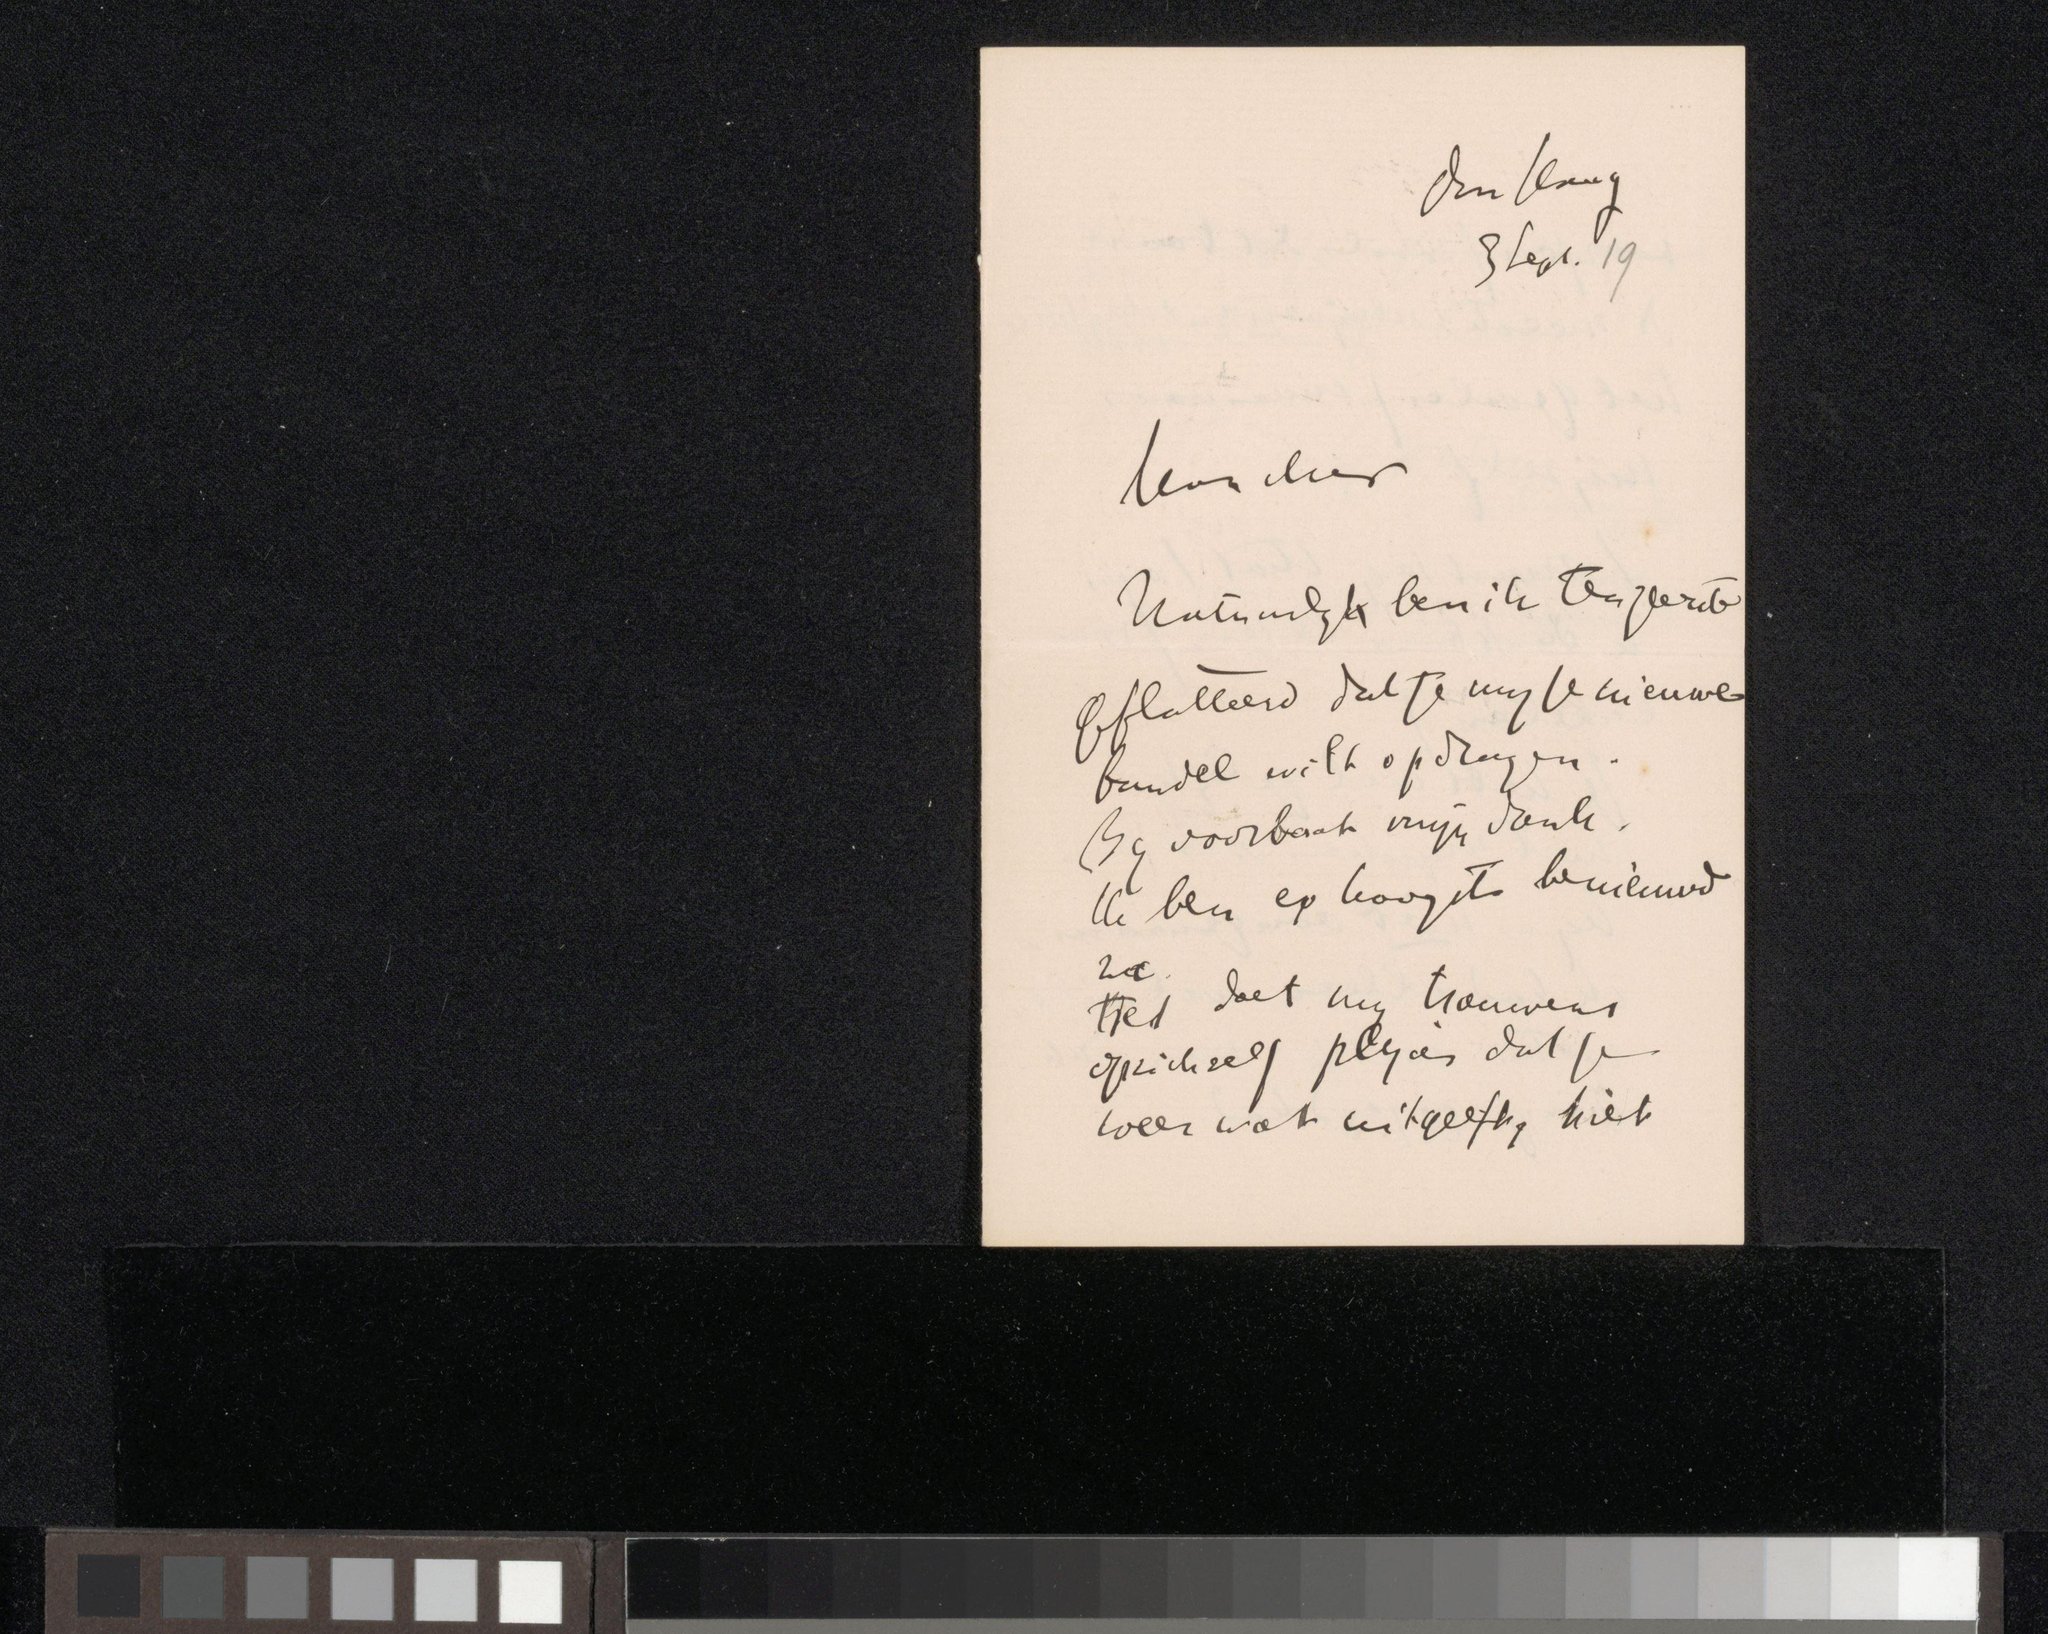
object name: letter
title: Brief aan Jan Veth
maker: isaac israels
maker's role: draughtsman, painter, print maker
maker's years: 1865-1934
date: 1875-1925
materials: ink, paper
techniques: pen, writing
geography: the hague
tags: painter, print maker, draughtsman, designer, jan veth, printed matter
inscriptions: watermark, collector's mark: ‘RPK’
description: Gedateerd 3 september. In latere hand 19.